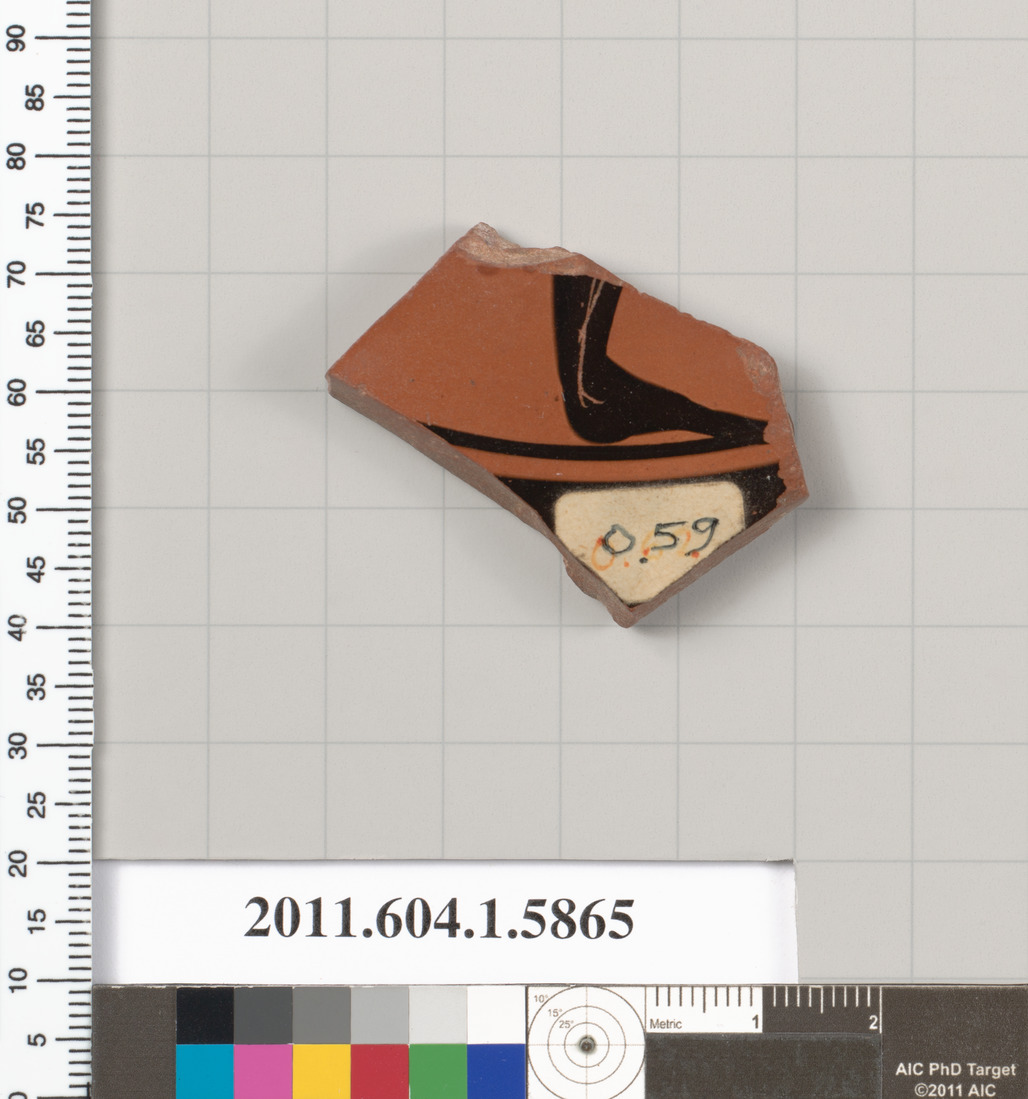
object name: kylix fragment, eye cup, bilingual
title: Terracotta fragment of a kylix (drinking cup)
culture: greek, attic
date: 433-567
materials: terracotta